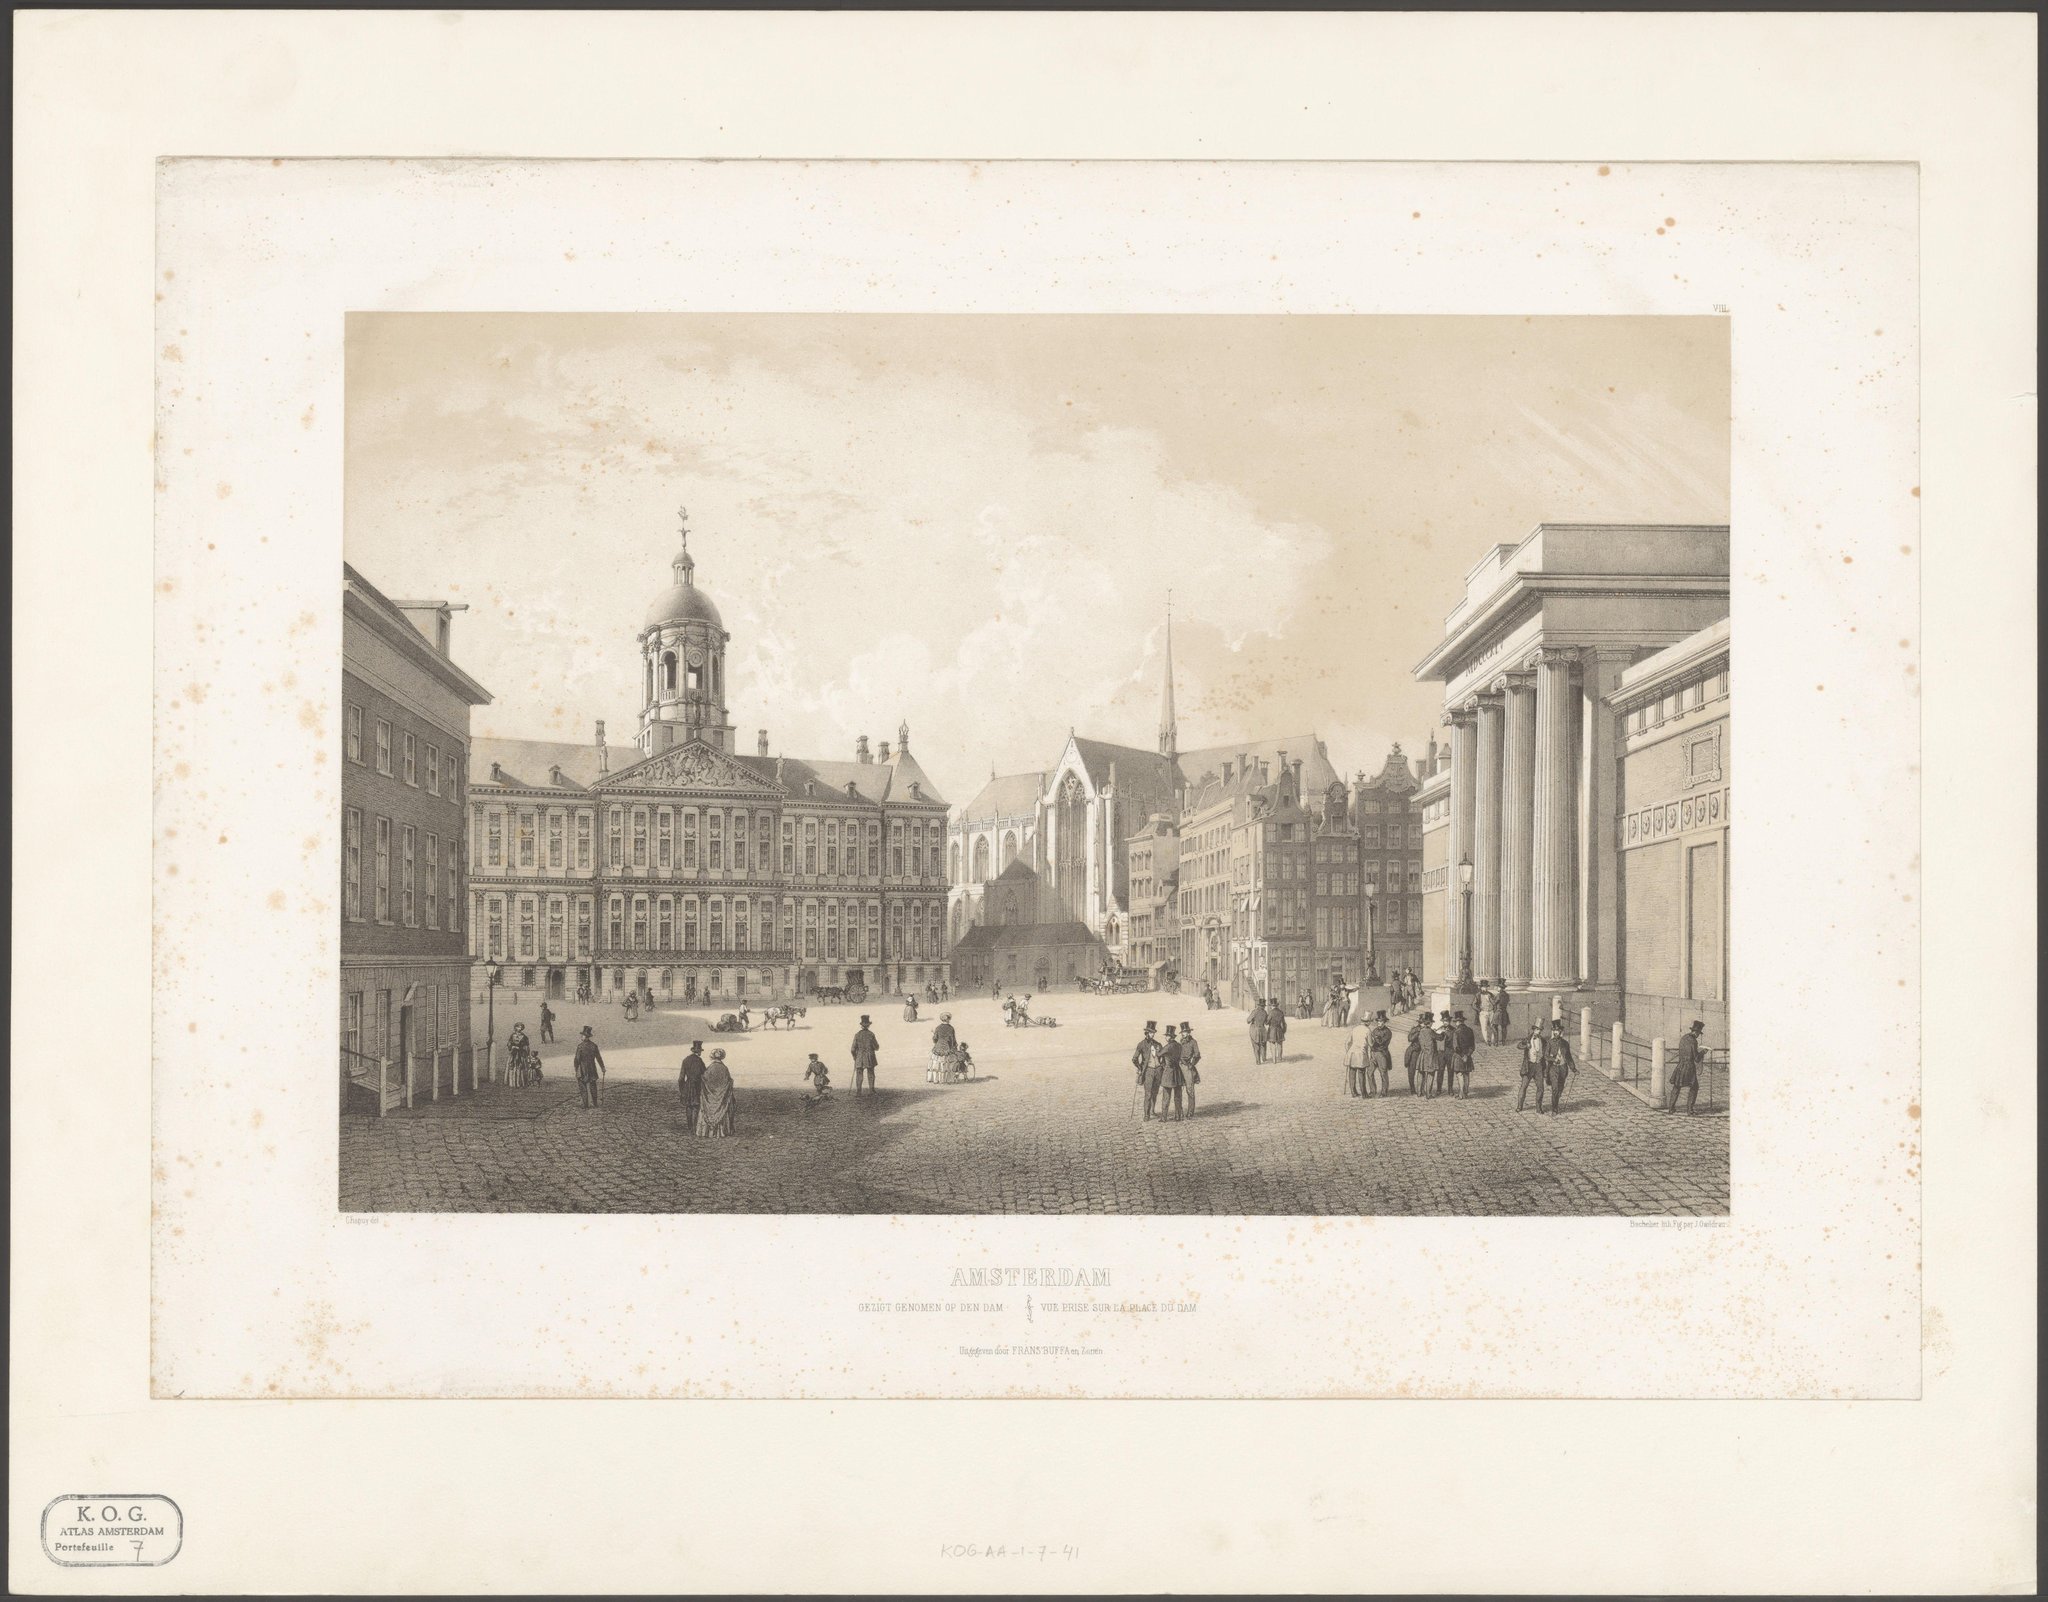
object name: print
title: Gezichten in Amsterdam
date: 1826-1858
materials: paper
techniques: tone lithography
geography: amsterdam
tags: square, place, circus, etc., city-view in general; 'veduta', palace, church (exterior), royal palace of amsterdam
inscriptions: collector's mark: ‘7’ Lugt 1641b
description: Onderwerpsrubriek binnen de Atlas Amsterdam: Dam (na 1835).